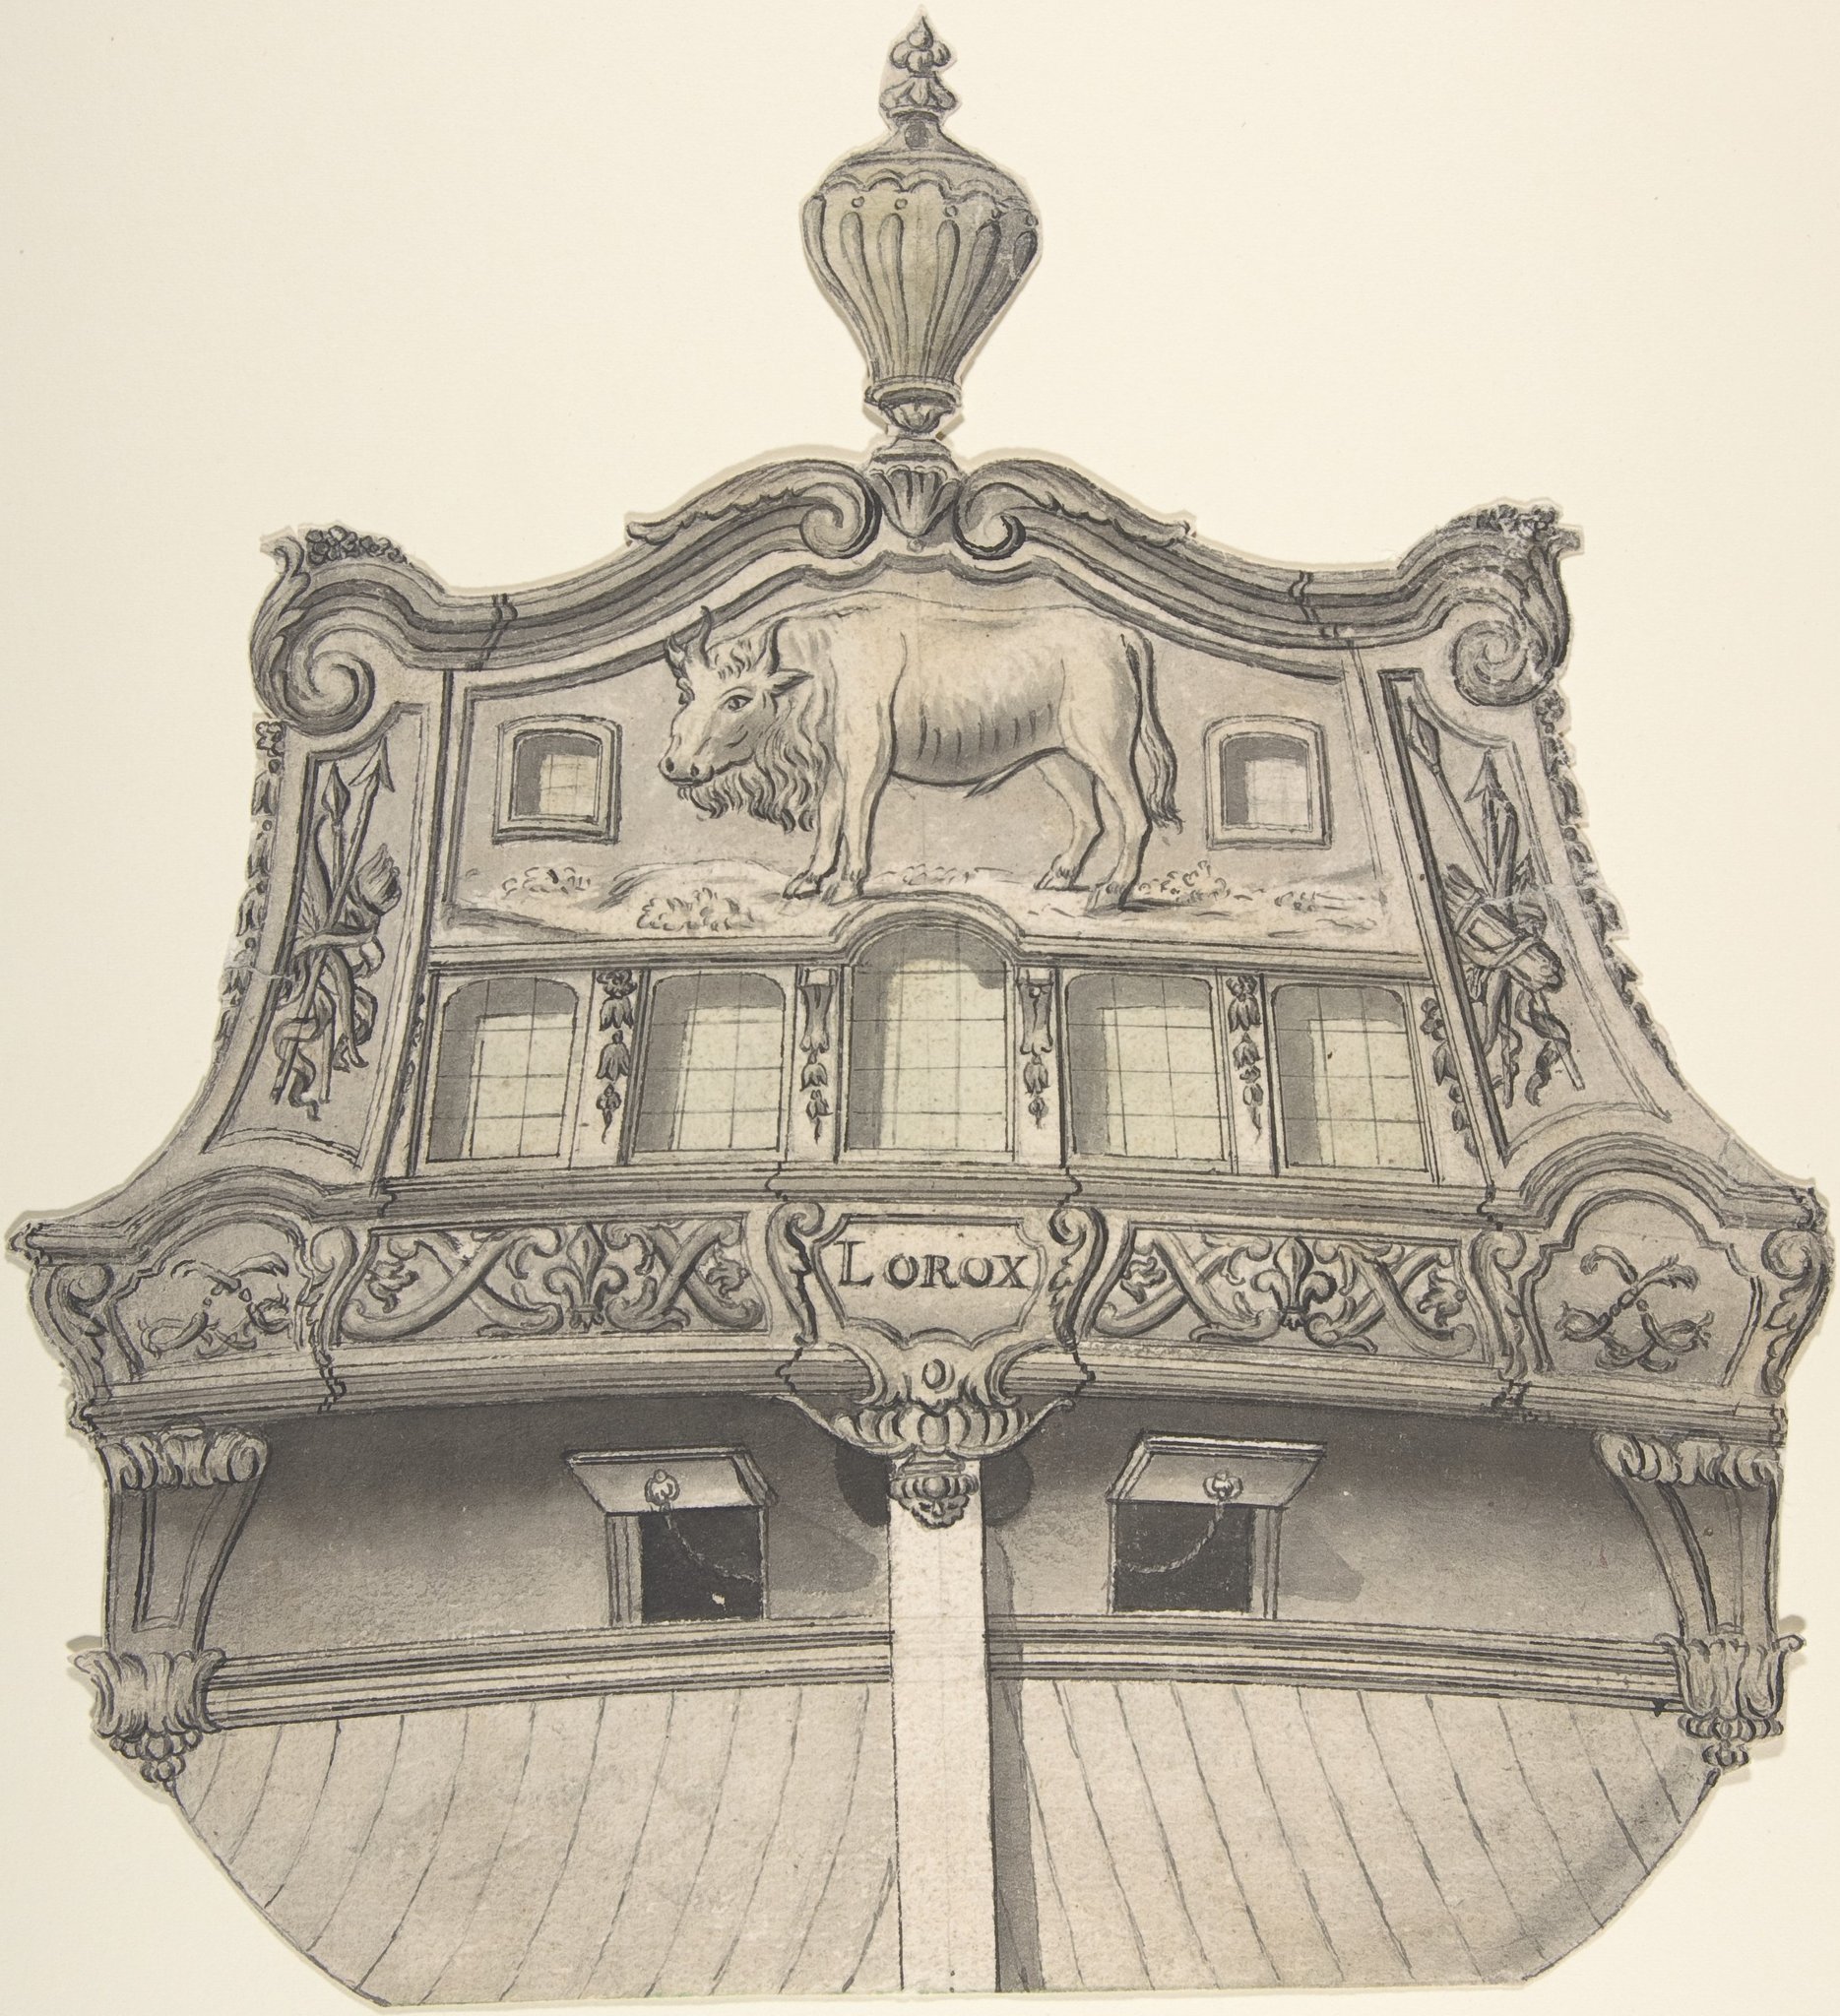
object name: drawing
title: Design for Stern of the Boat "Lorox"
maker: anonymous, french, 18th century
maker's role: artist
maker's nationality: french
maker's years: 1700-1800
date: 1757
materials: ink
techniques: brush, pen, wash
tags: bulls,boats